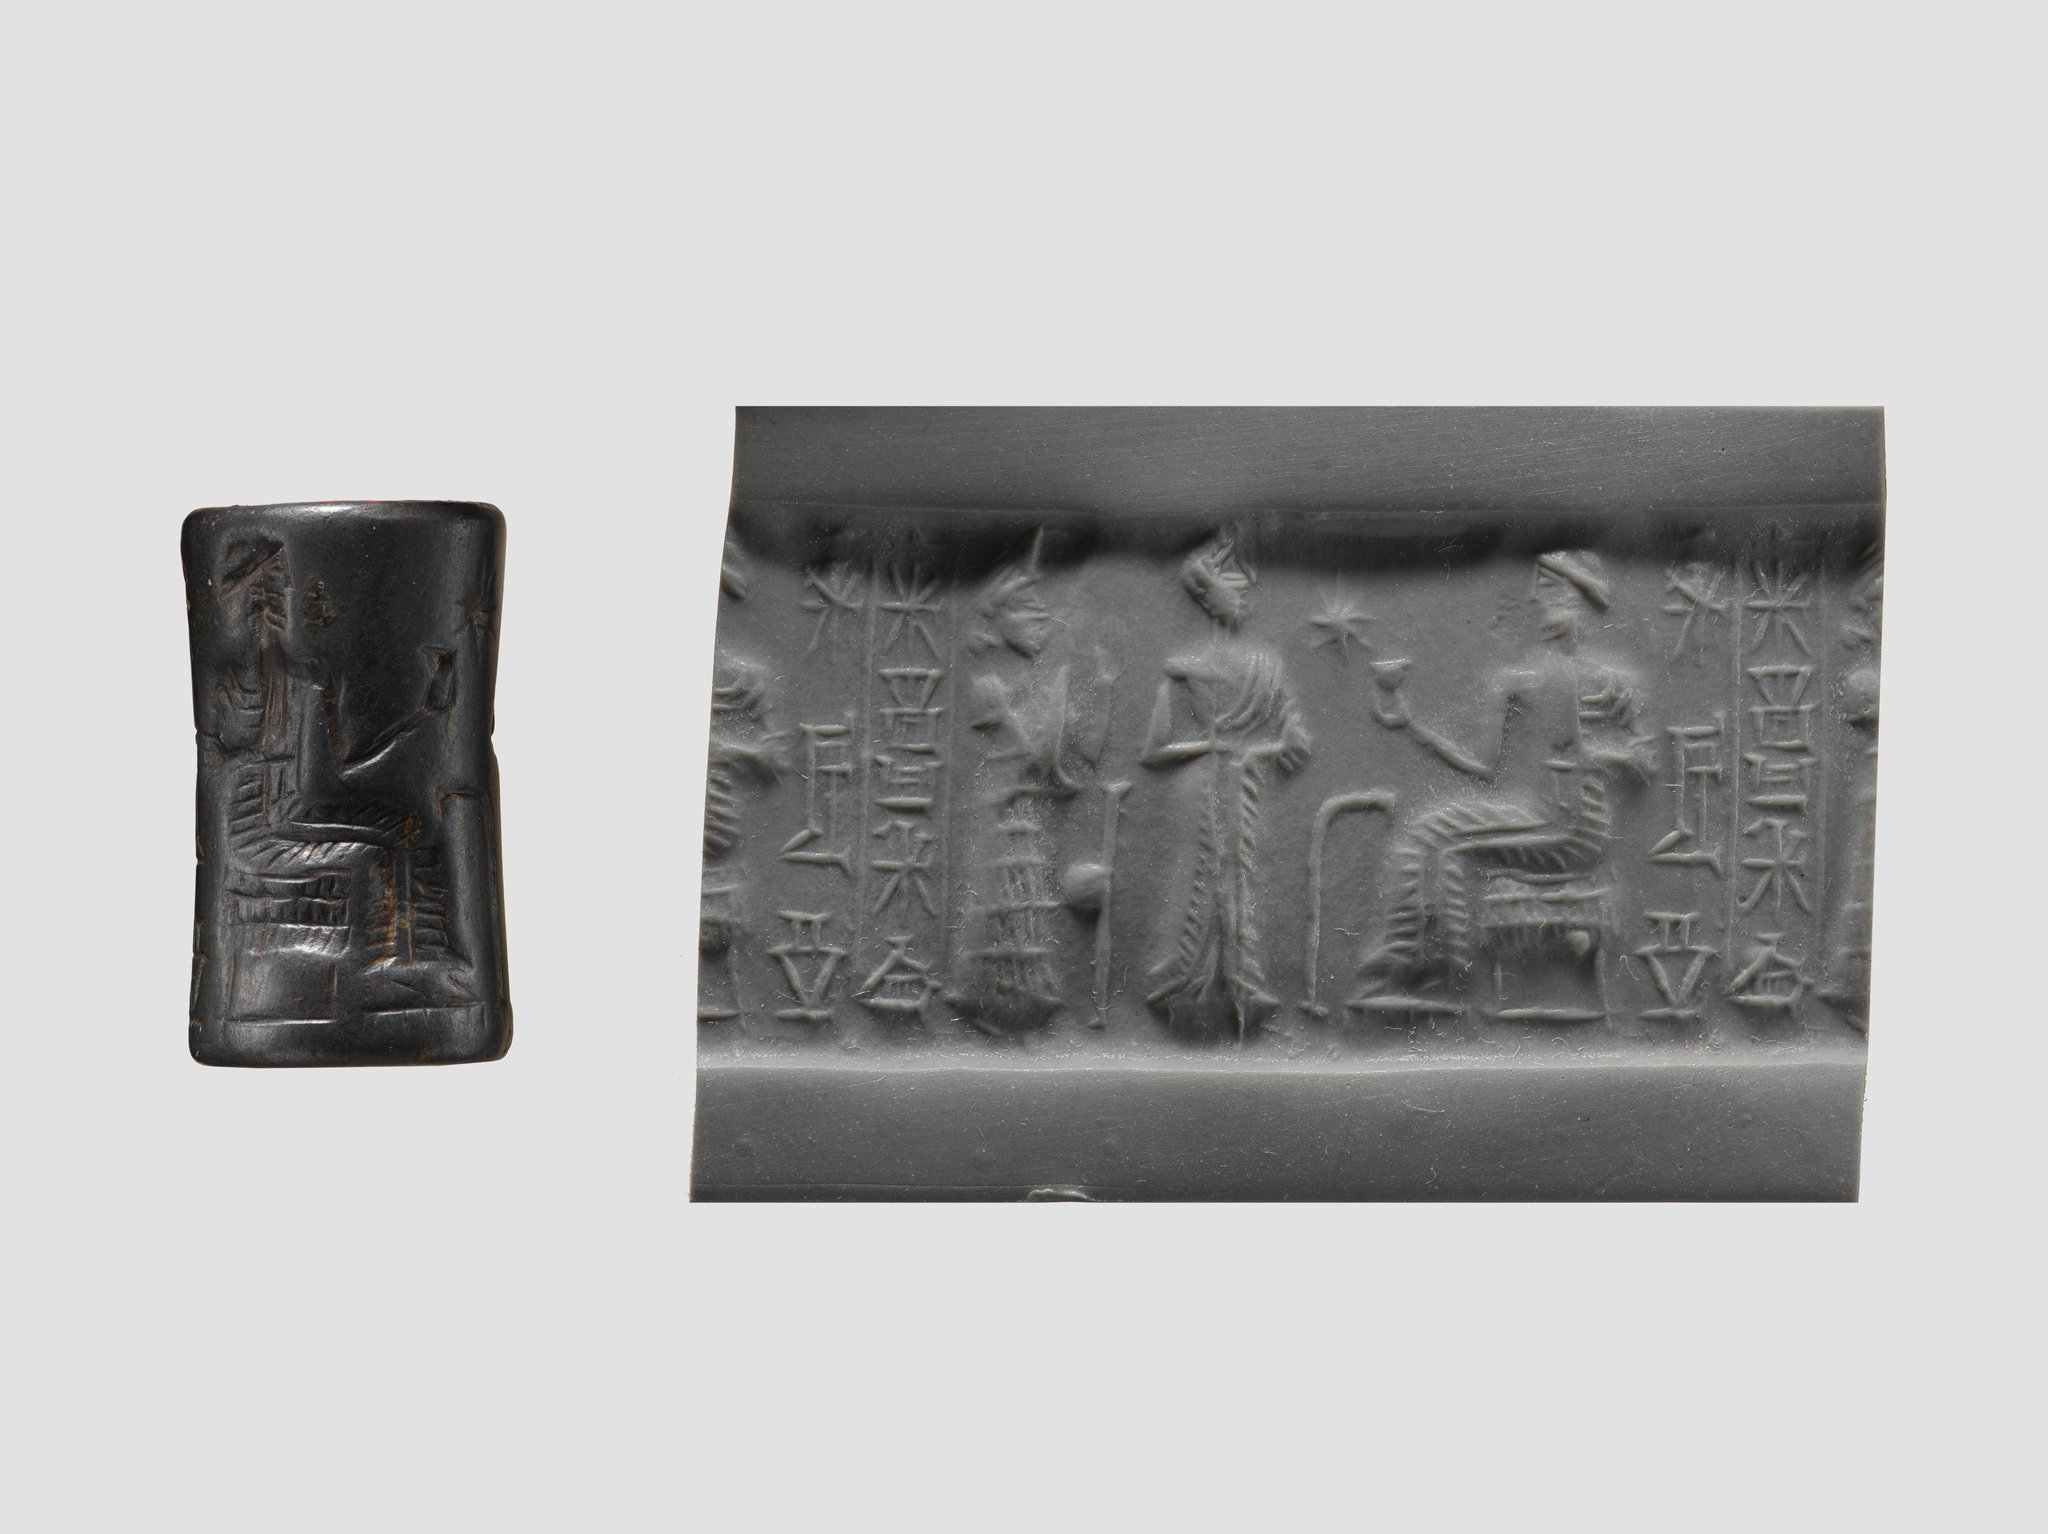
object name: cylinder seal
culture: babylonian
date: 2000-1668 BCE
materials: mineral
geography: mesopotamia